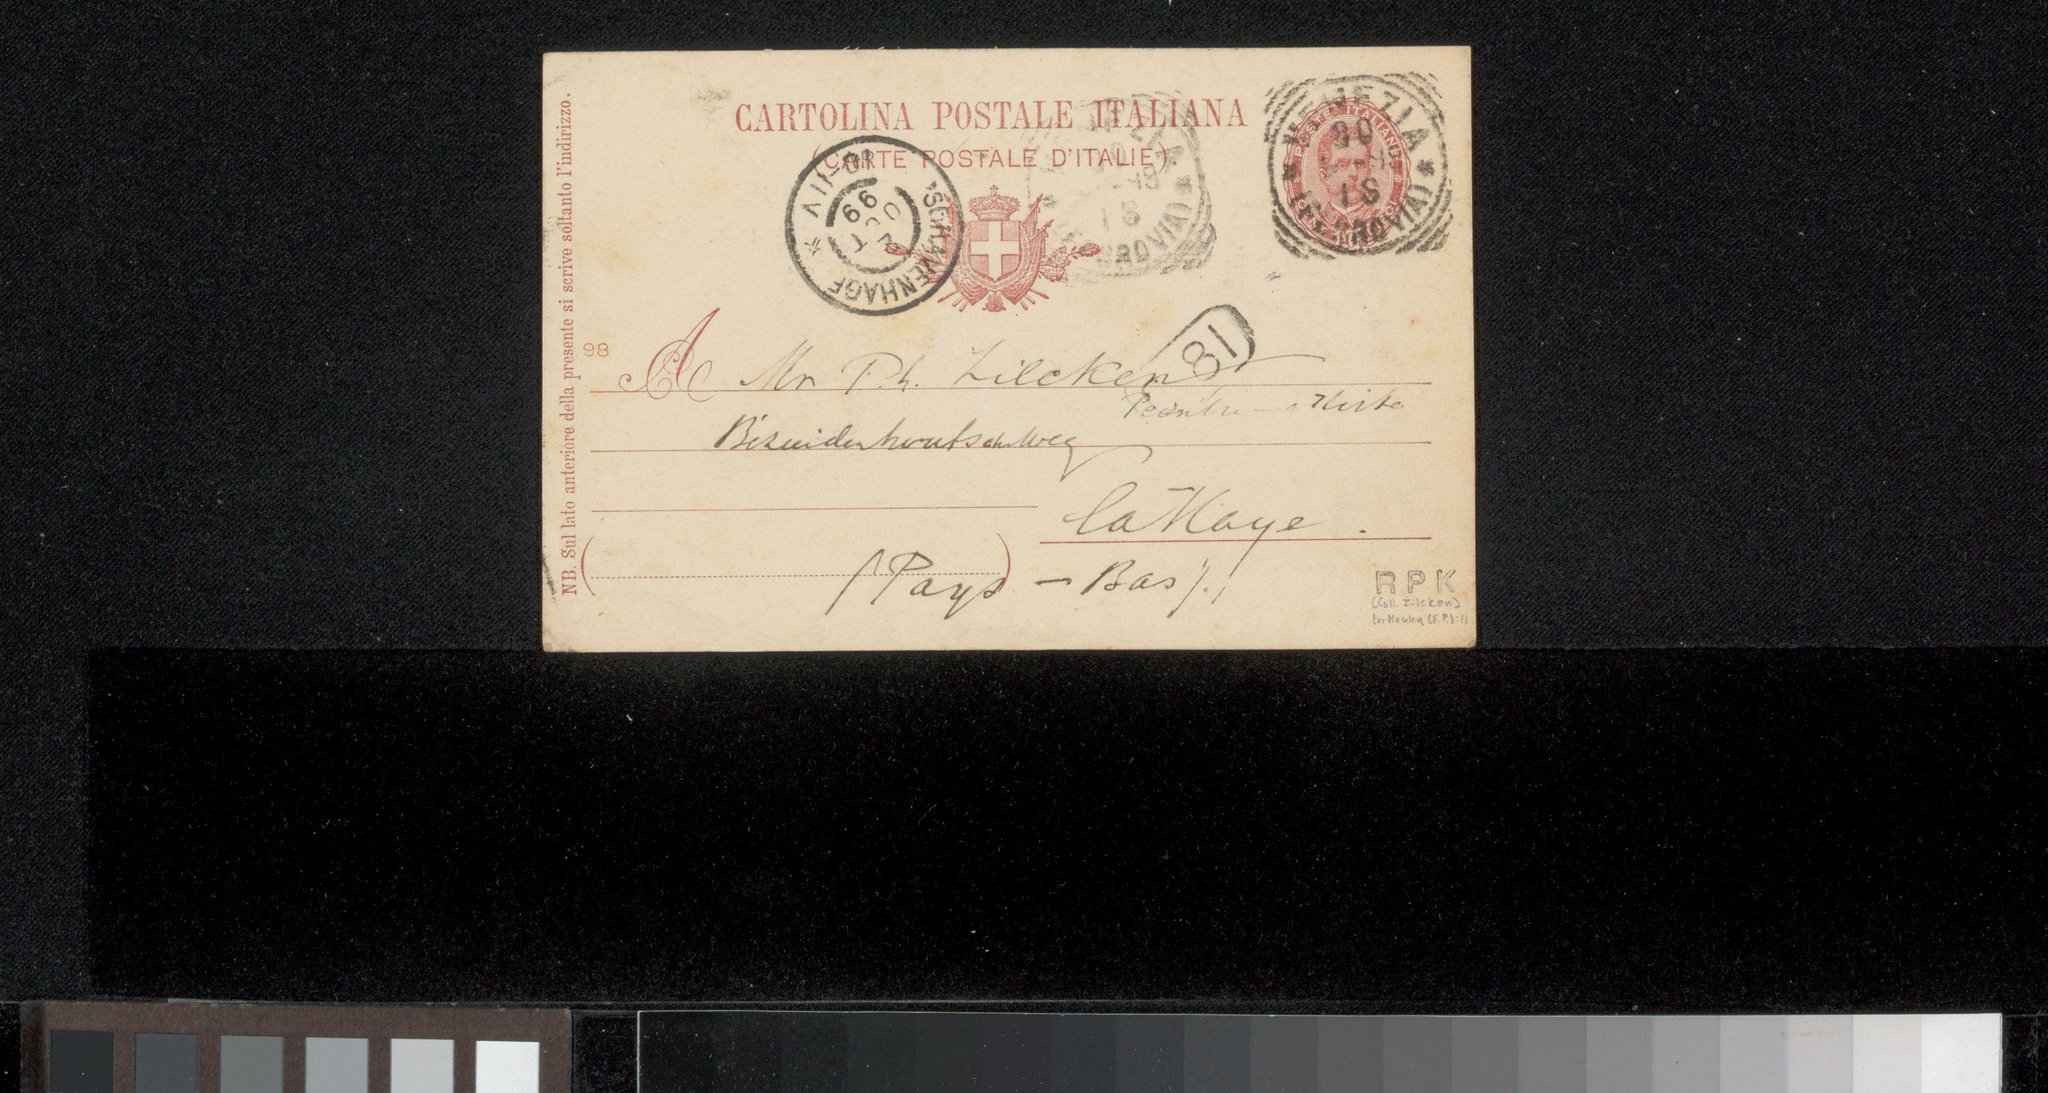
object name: postcard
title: Briefkaart aan Philip Zilcken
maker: françois pieter ter meulen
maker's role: painter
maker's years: 1843-1927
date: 1899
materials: cardboard, ink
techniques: pen, writing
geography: venice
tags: draughtsman, philip zilcken, painting (including book-illumination, miniature-painting), exhibition ~ art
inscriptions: collector's mark: ‘RPK’